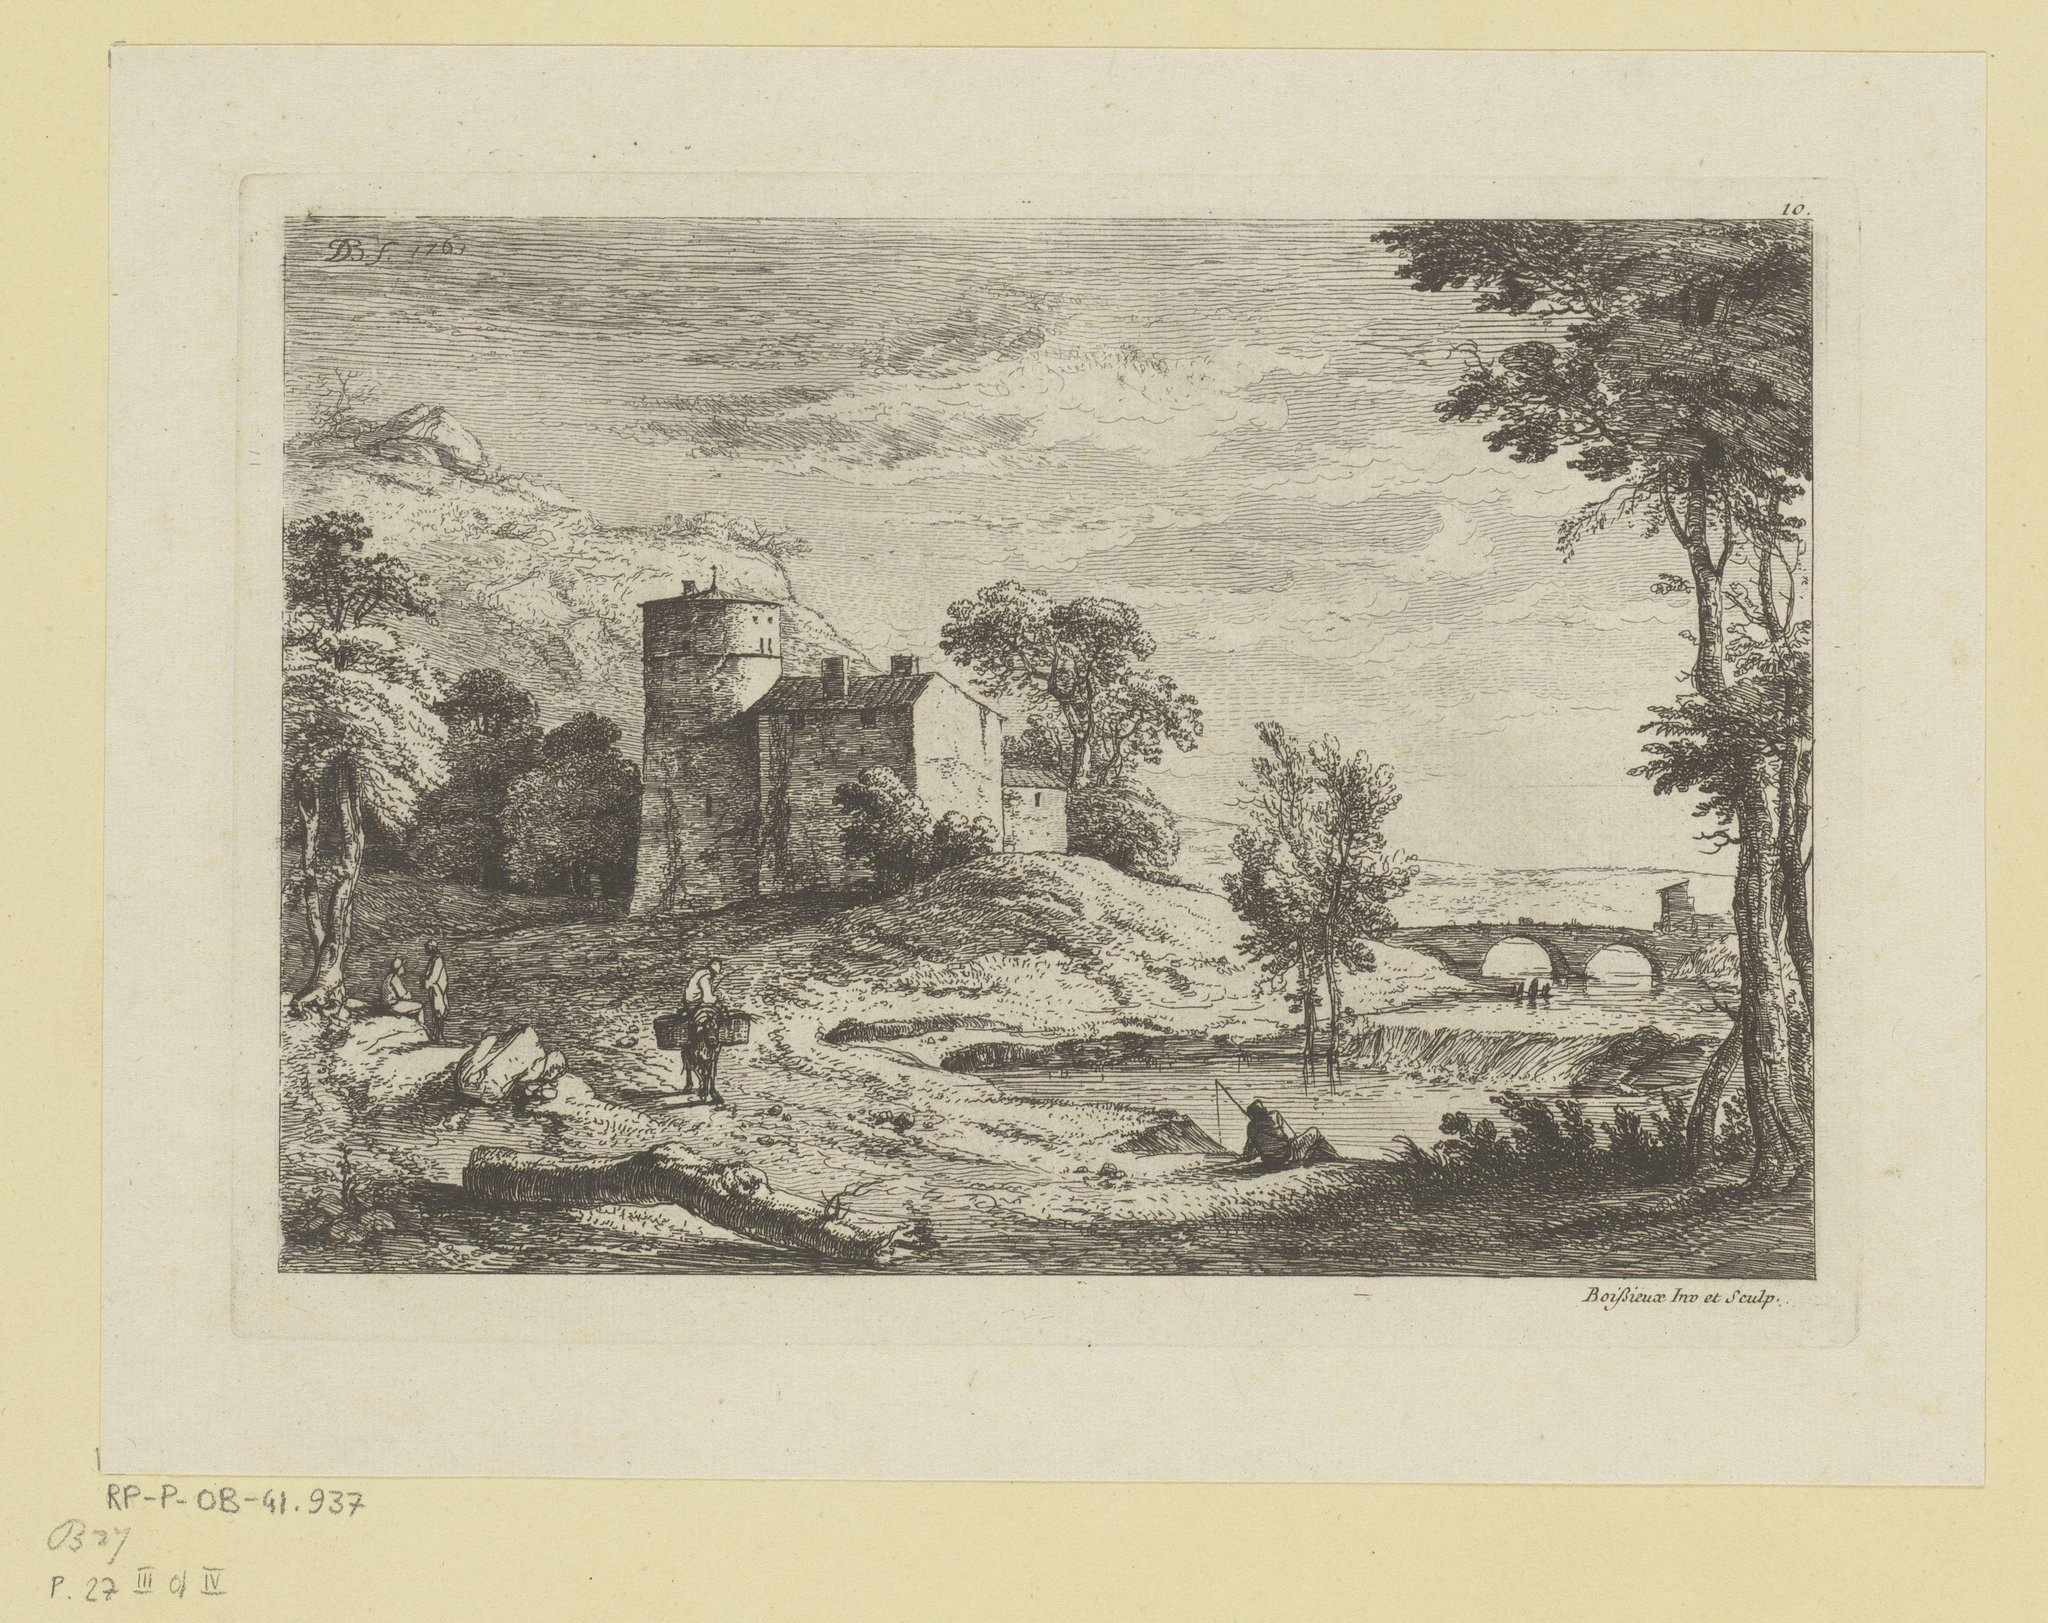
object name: print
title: Landschap met een boer op een ezel en een visser aan een rivier met stenen brug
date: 1763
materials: paper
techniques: drypoint, etching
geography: paris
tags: ass, donkey, landscape with bridge, viaduct or aqueduct, landscapes (+ landscape with figures, staffage), angling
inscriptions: collector's mark: Lugt 12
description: Maakt deel uit van een tiendelige serie met landschappen, uitgegeven door Basan te Parijs in 1763.